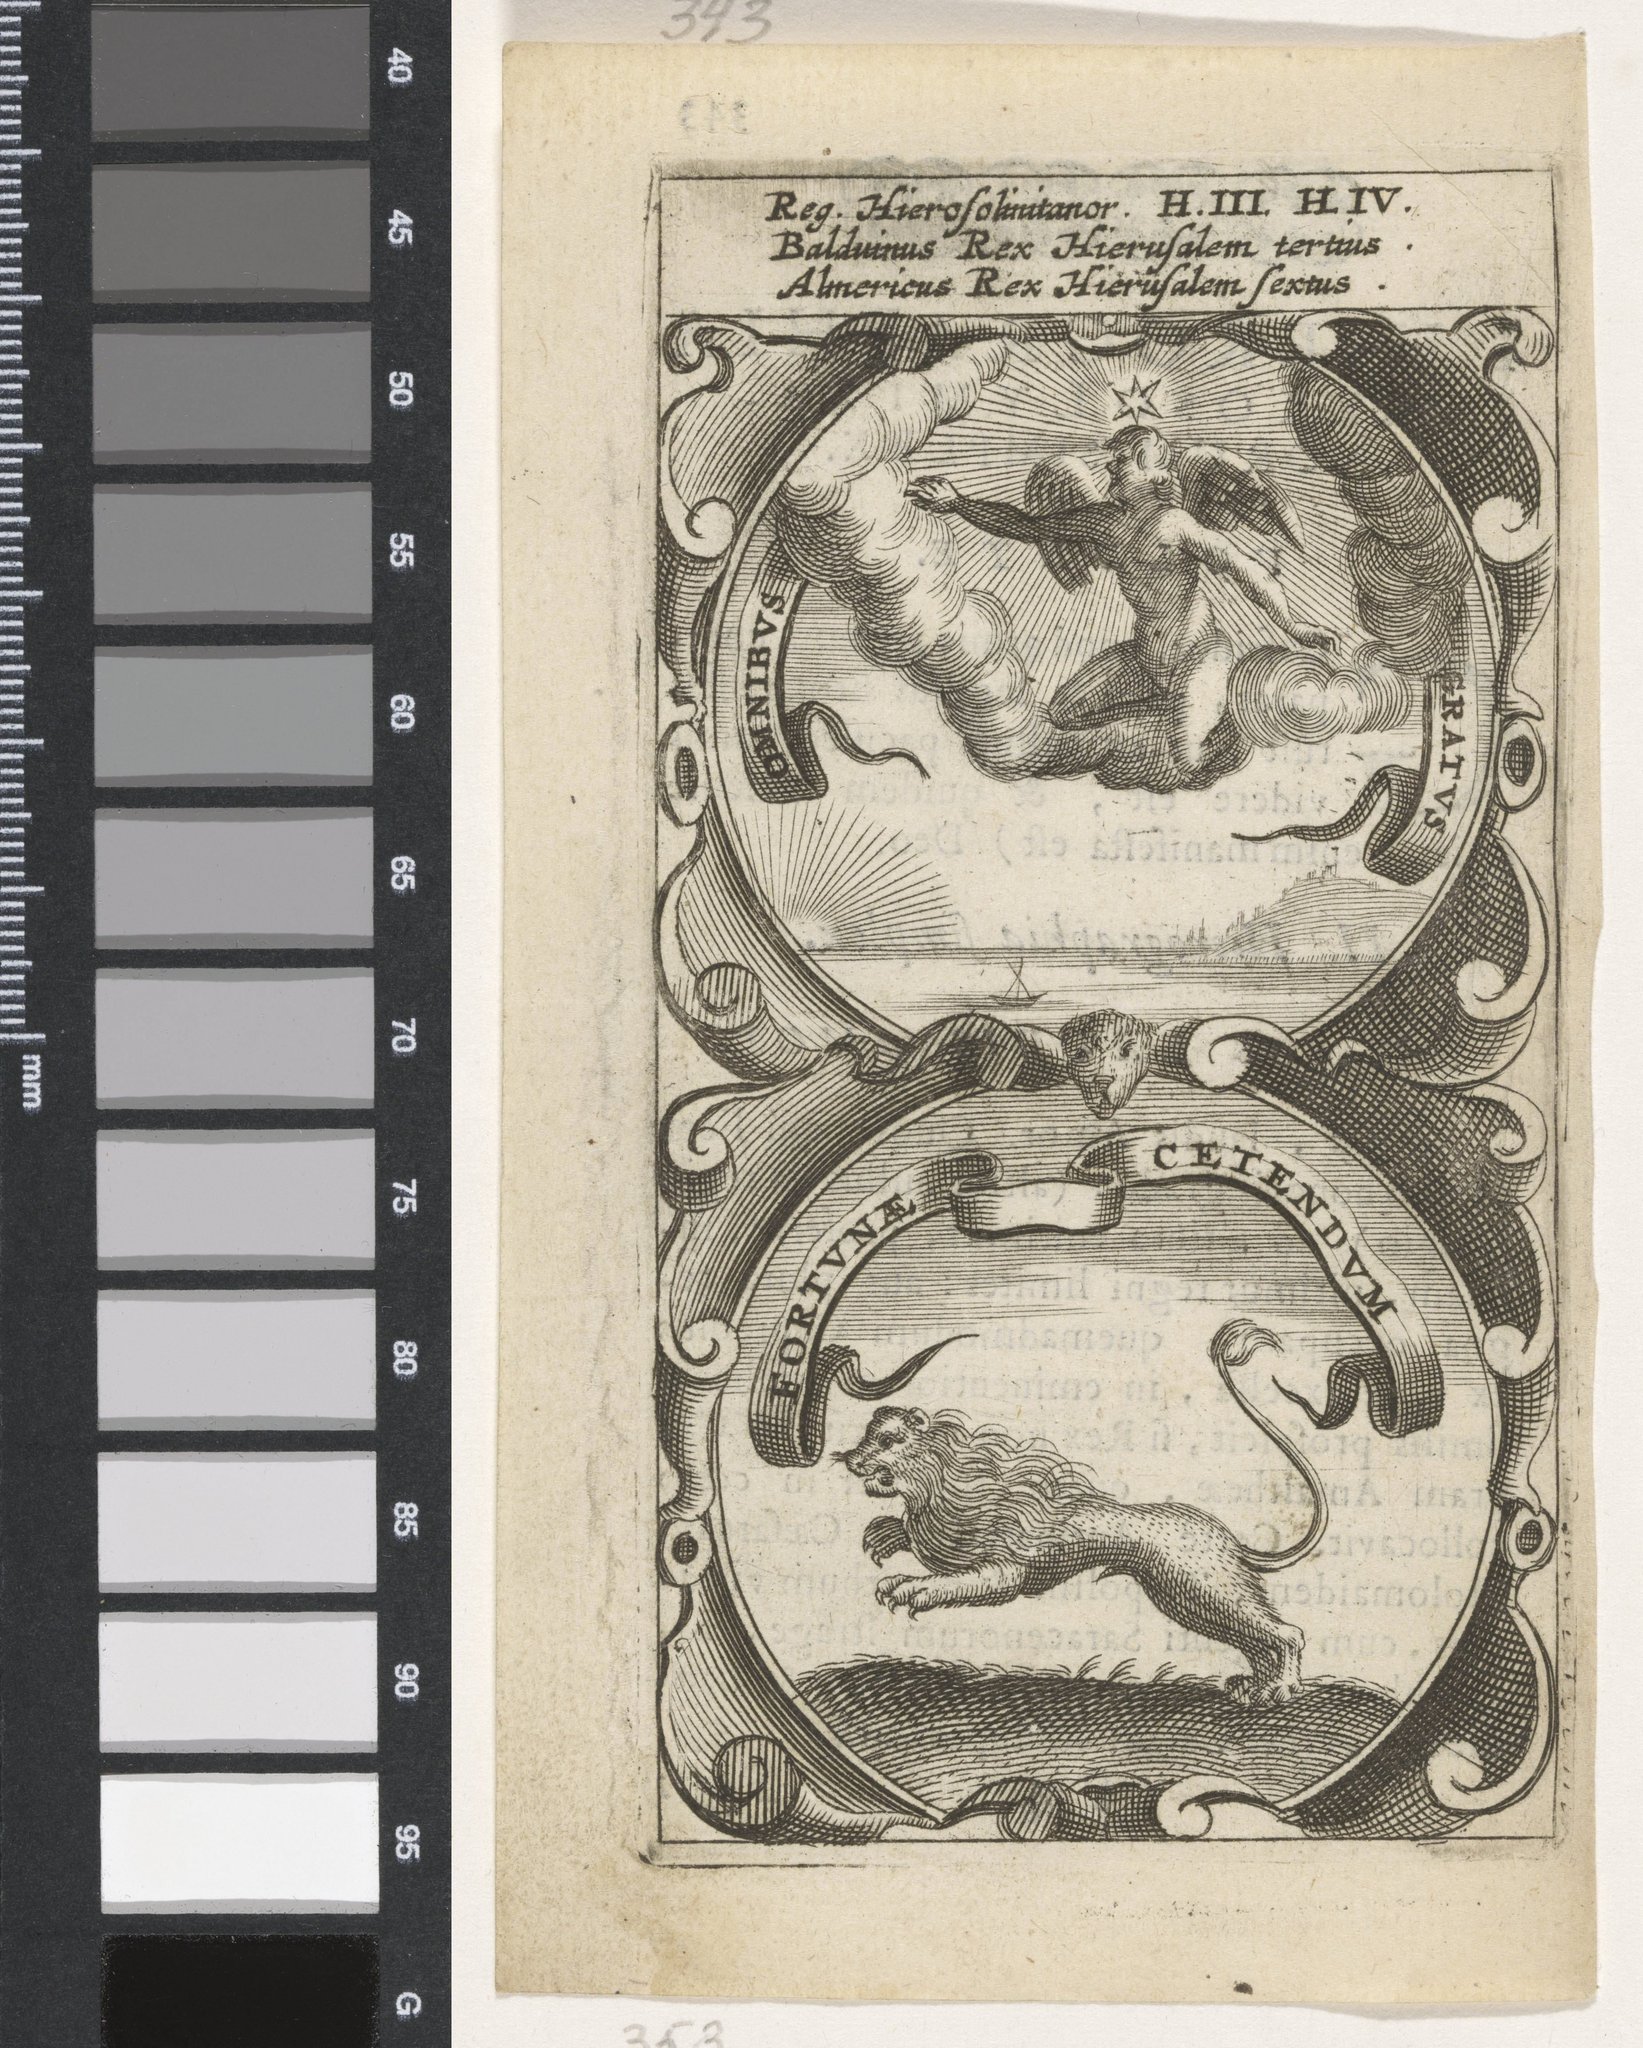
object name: book illustration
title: Engel in de wolken / Aanvallende leeuw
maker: Anonymous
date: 1666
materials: paper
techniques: engraving, letterpress printing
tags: clouds, beasts of prey, predatory animals: lion, angels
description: Een embleem met twee voorstellingen. Boven een landschap met opkomende zon en een schip op zee. In de wolken daarboven een engel met een ster boven zijn hoofd. Onder een aanvallende leeuw. Het betreffen deviezen van Boudewijn III en Amalrik I van Jeruzalem.